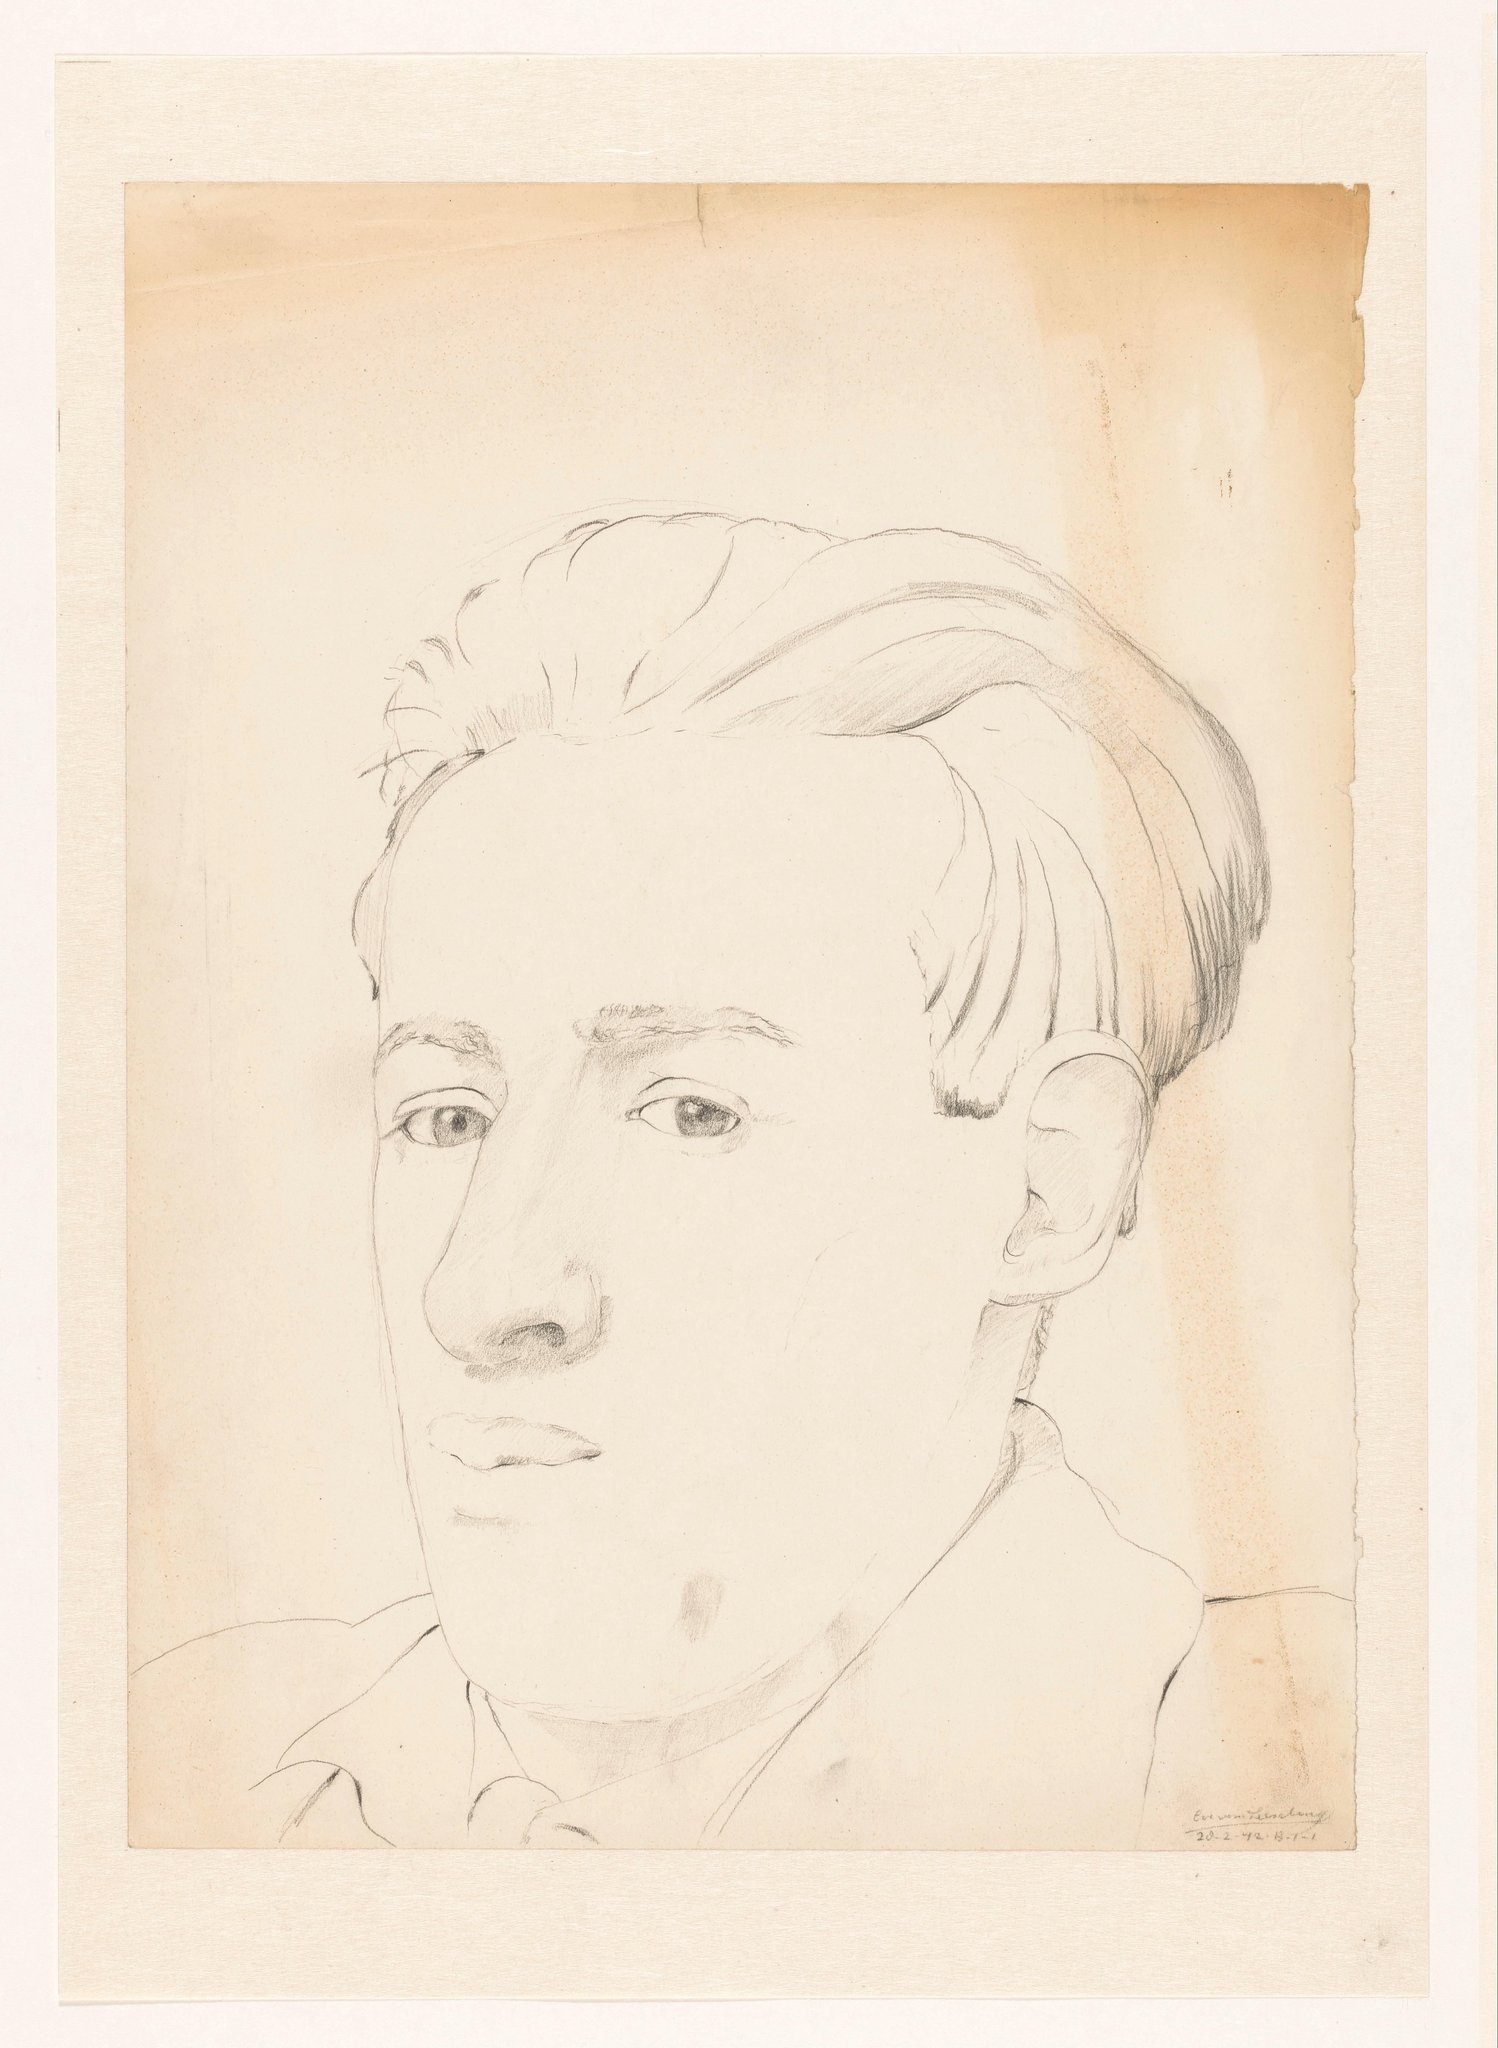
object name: drawing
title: Zelfportret: B-1-1, 28 februari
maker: cor van teeseling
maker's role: draughtsman, sculptor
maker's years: 1915-1942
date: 1942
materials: paper, pencil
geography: weteringschans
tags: amsterdam, draughtsman, sculptor, cor van teeseling, historical persons, prisoner in cell or locked place, portrait, self-portrait of draughtsman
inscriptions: signature and date: ‘Cor van Teeseling / 20-2-42 B-1-1’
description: Zelfportret van Cor van Teeseling driekwart, naar links kijkend: B-1-1, 28 februari.